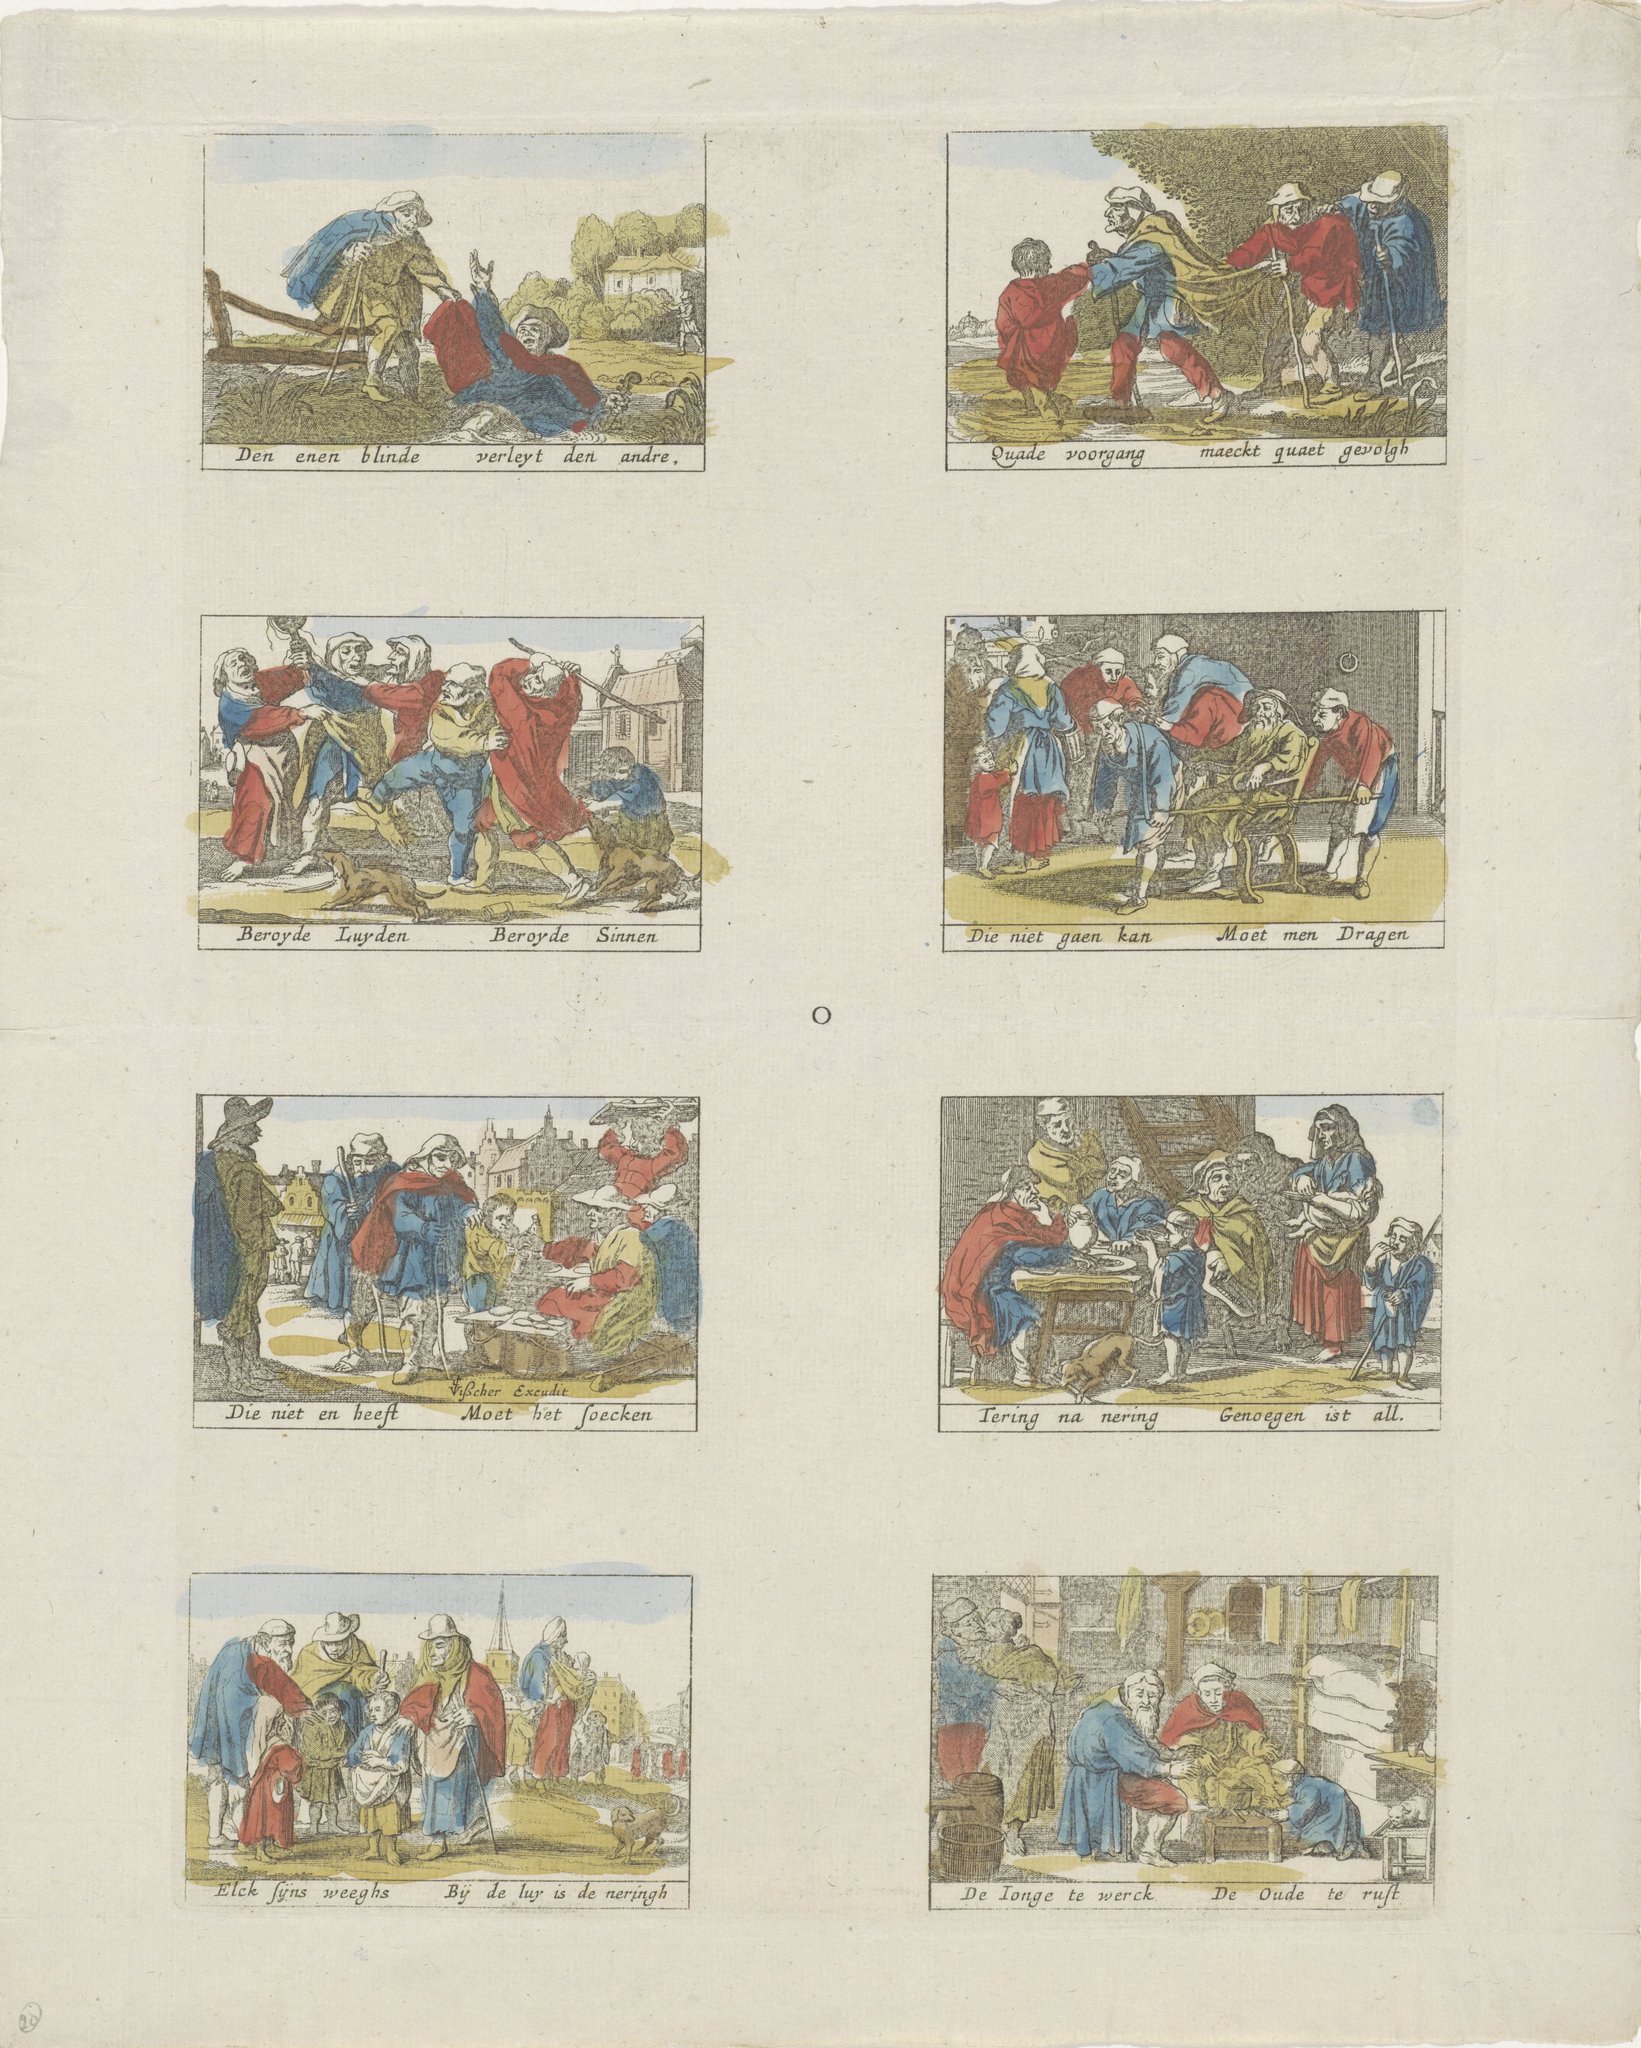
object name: popular print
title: Spreekwoorden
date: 1601-1652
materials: paper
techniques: etching, hand coloring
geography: netherlands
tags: proverbs, sayings, etc.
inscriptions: collector's mark: Lugt 2760, collector's mark: Lugt 2228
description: Blad met 8 voorstellingen van spreekwoorden, waaronder 'Den enen blinde verleyt den andre', 'Quade voorgang maeckt quaet gevolgh' en 'De jonge te werck De oude te rust'. Onder elke afbeelding een onderschrift. Gemerkt midden: O.